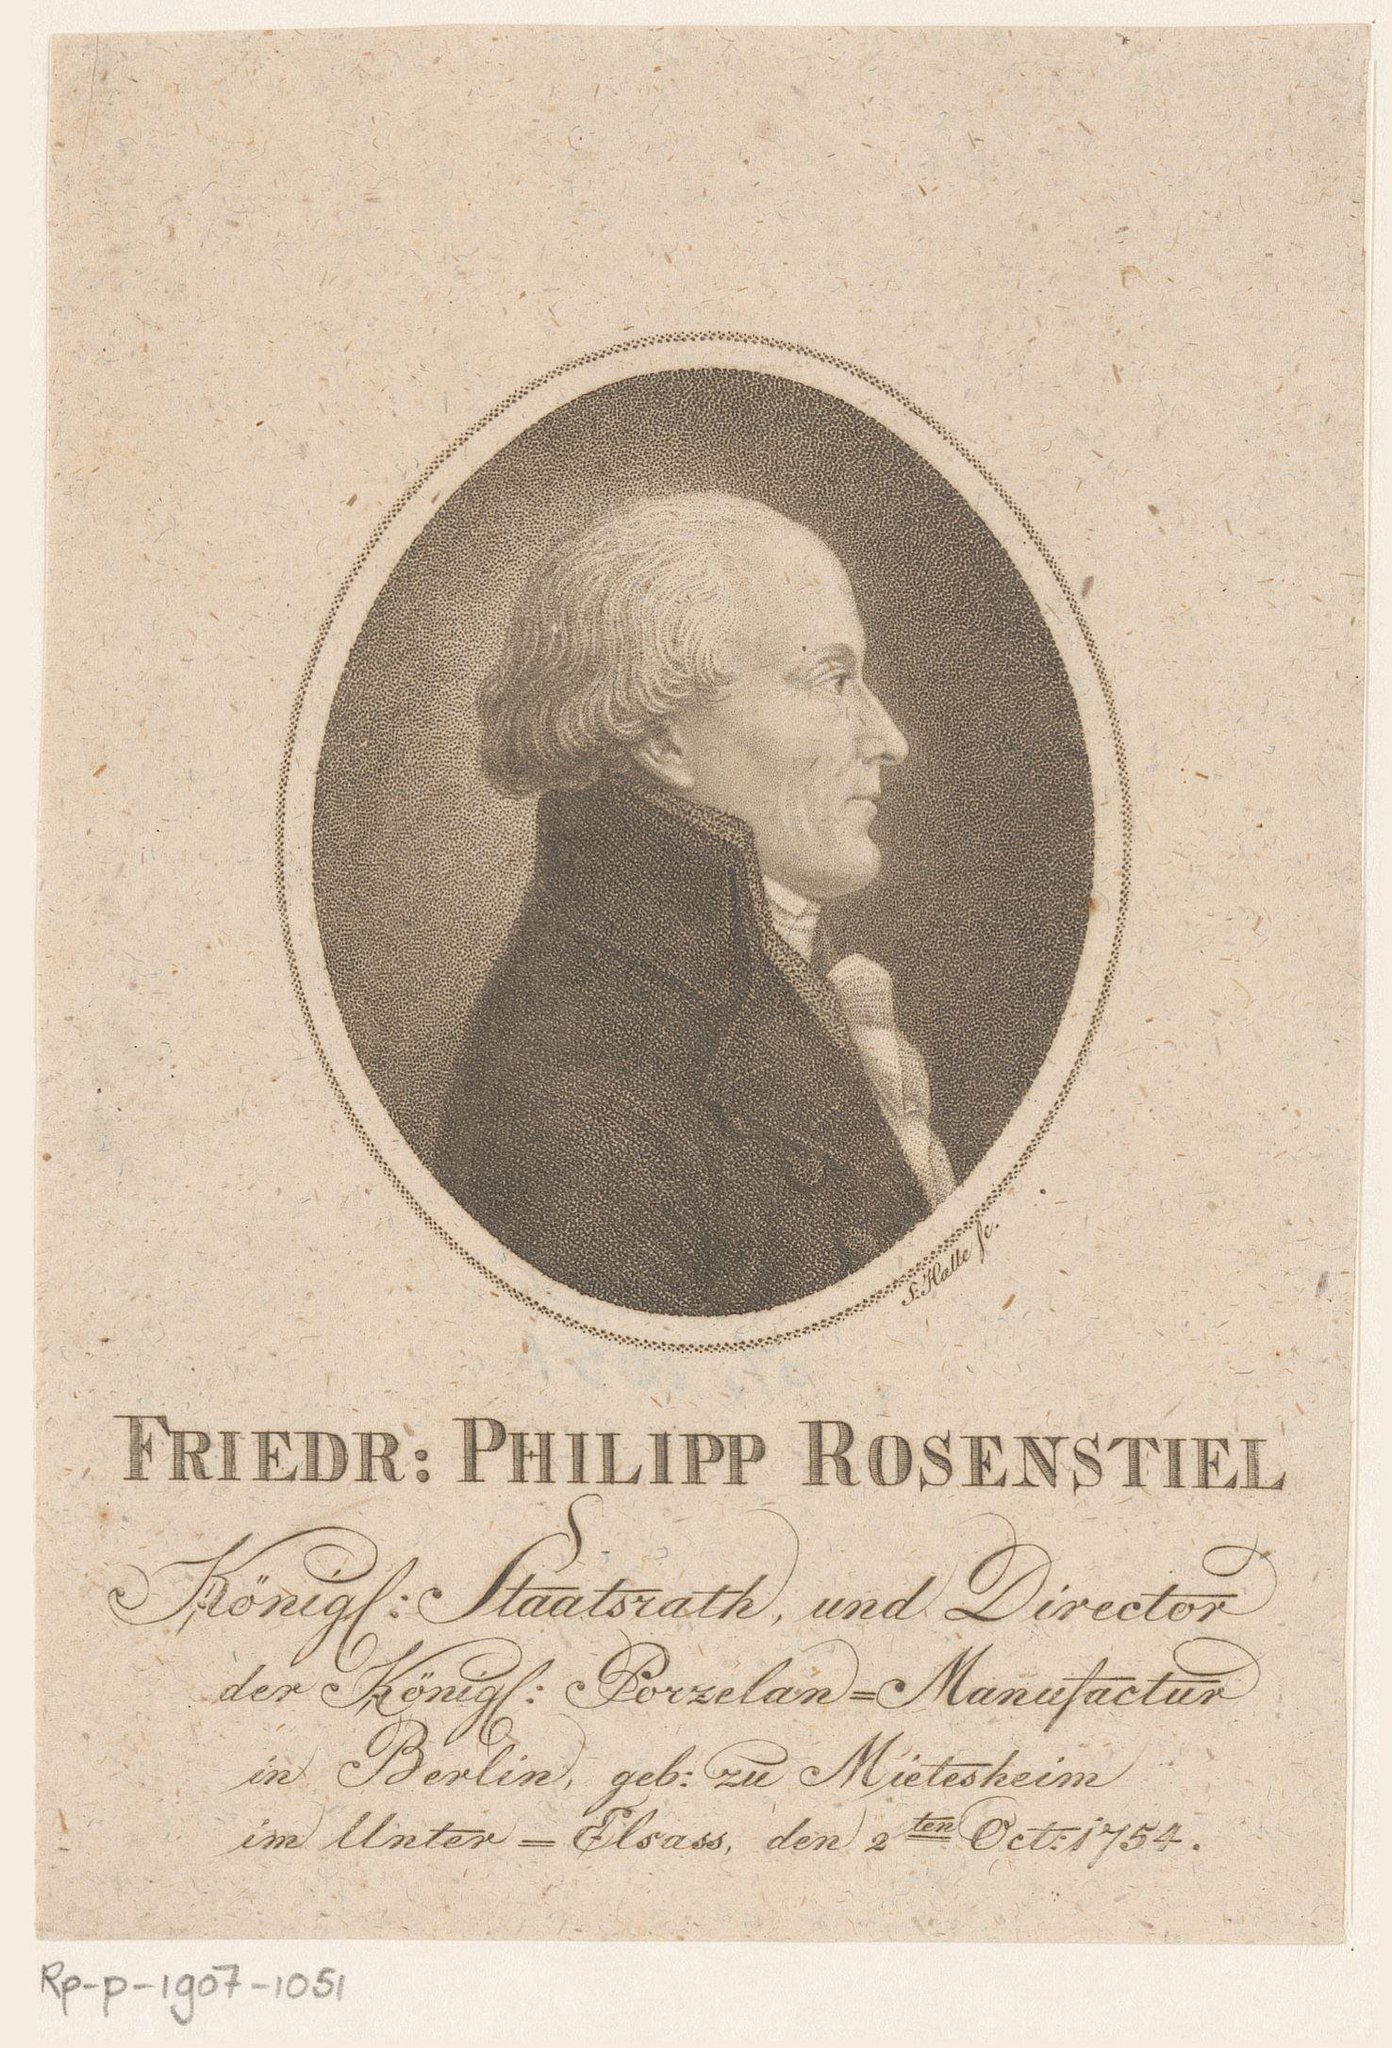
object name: print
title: Portret van Friedrich Philipp Rosenstiel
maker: johann samuel ludwig halle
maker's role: print maker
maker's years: 1763-1829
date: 1764-1832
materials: paper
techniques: stippling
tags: historical persons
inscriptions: collector's mark: Lugt 2228